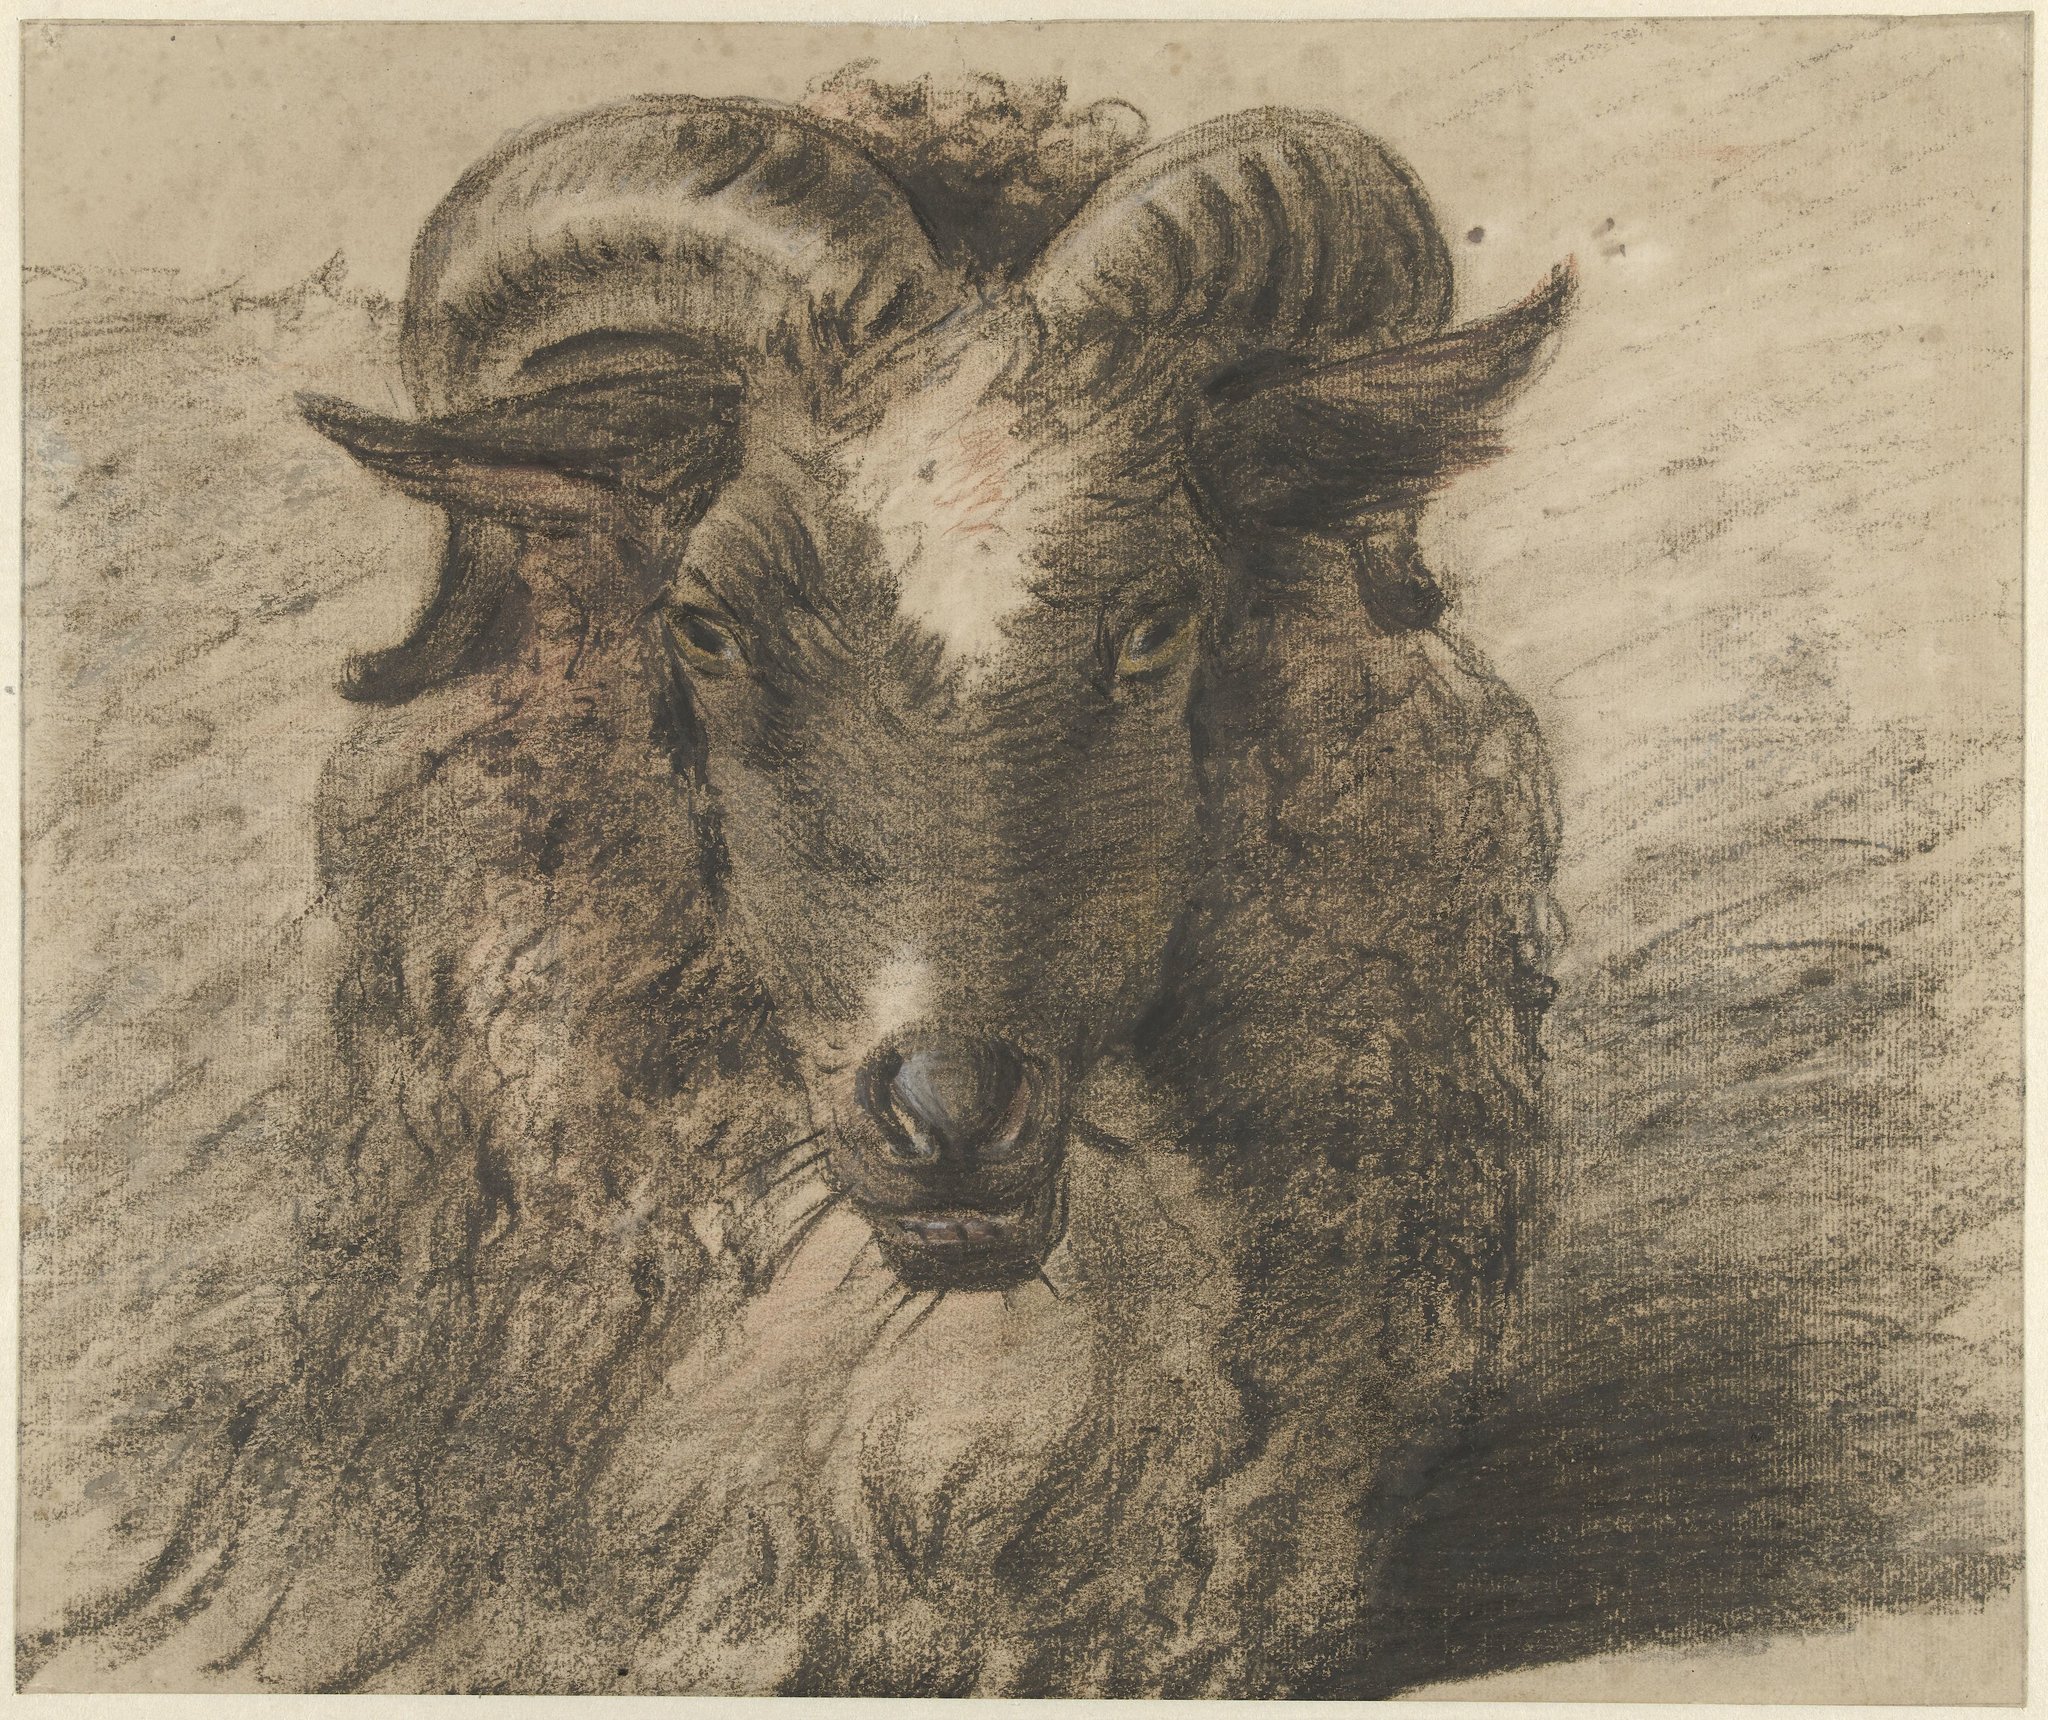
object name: drawing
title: Kop van een ram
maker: hendrik stokvisch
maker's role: draughtsman, painter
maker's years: 1768-1820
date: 1778-1820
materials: chalk, paper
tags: ram (+ aids ~ crafts, industries, agriculture)